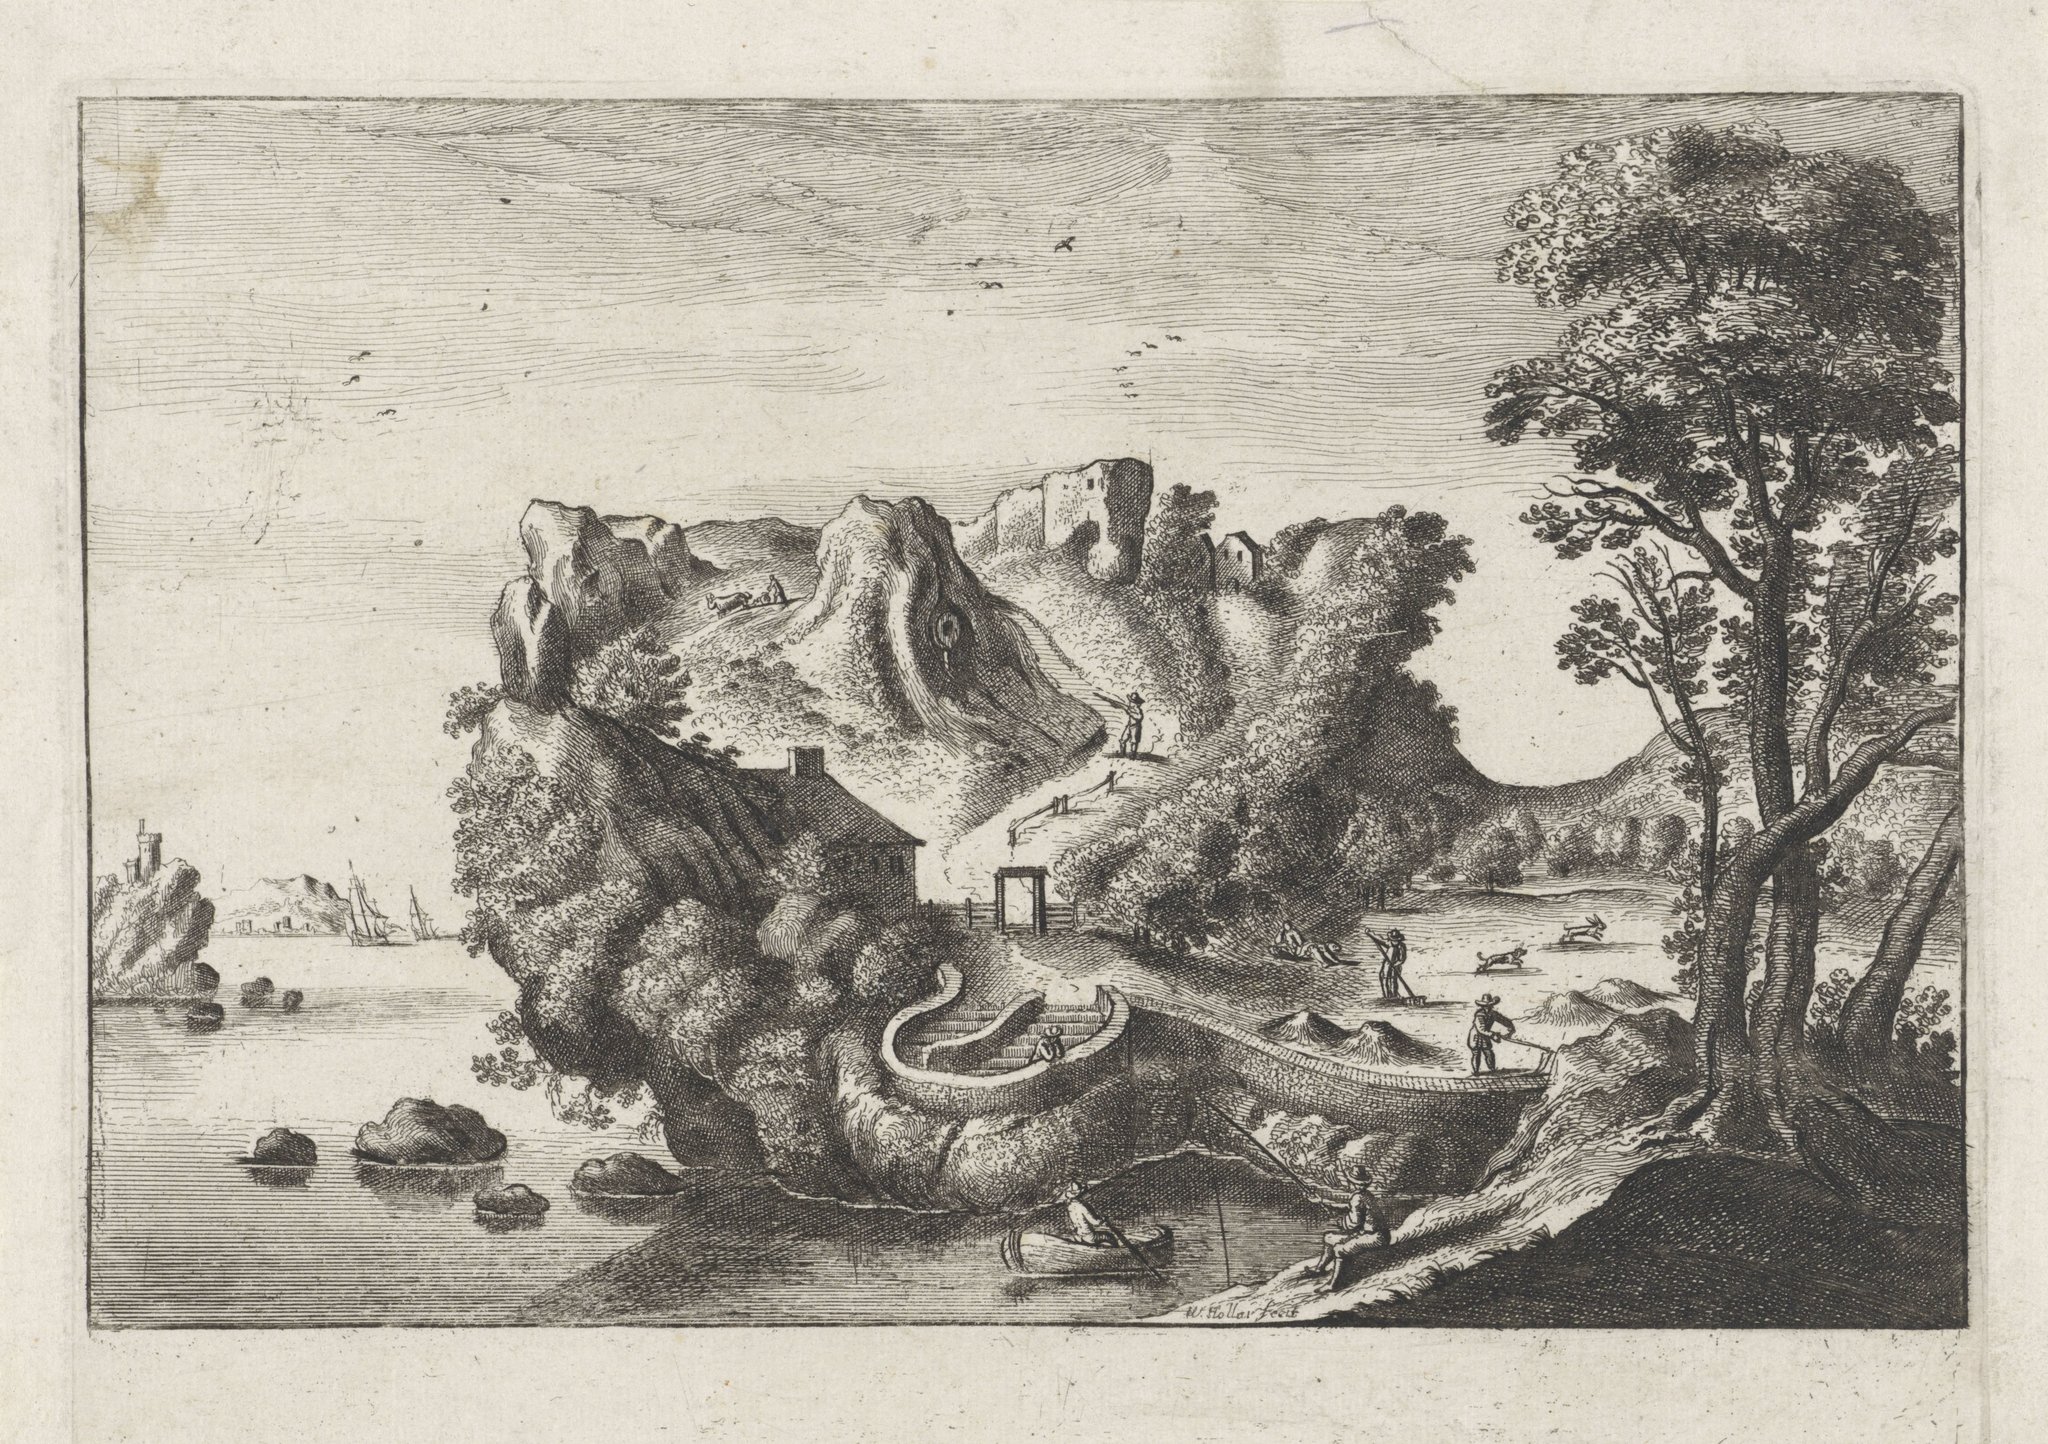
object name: print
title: Landschap in de vorm van een mannenhoofd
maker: wenceslaus hollar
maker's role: draughtsman, print maker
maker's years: 1607-1677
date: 1625-1677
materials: paper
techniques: etching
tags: landscapes with waters, waterscapes, seascapes (in the temperate zone), anthropomorphic beings (legendary or not) with heads, limbs or organs of an abnormal number, in abnormal places or of an abnormal shape) (+ variant)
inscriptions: collector's mark: Lugt 240